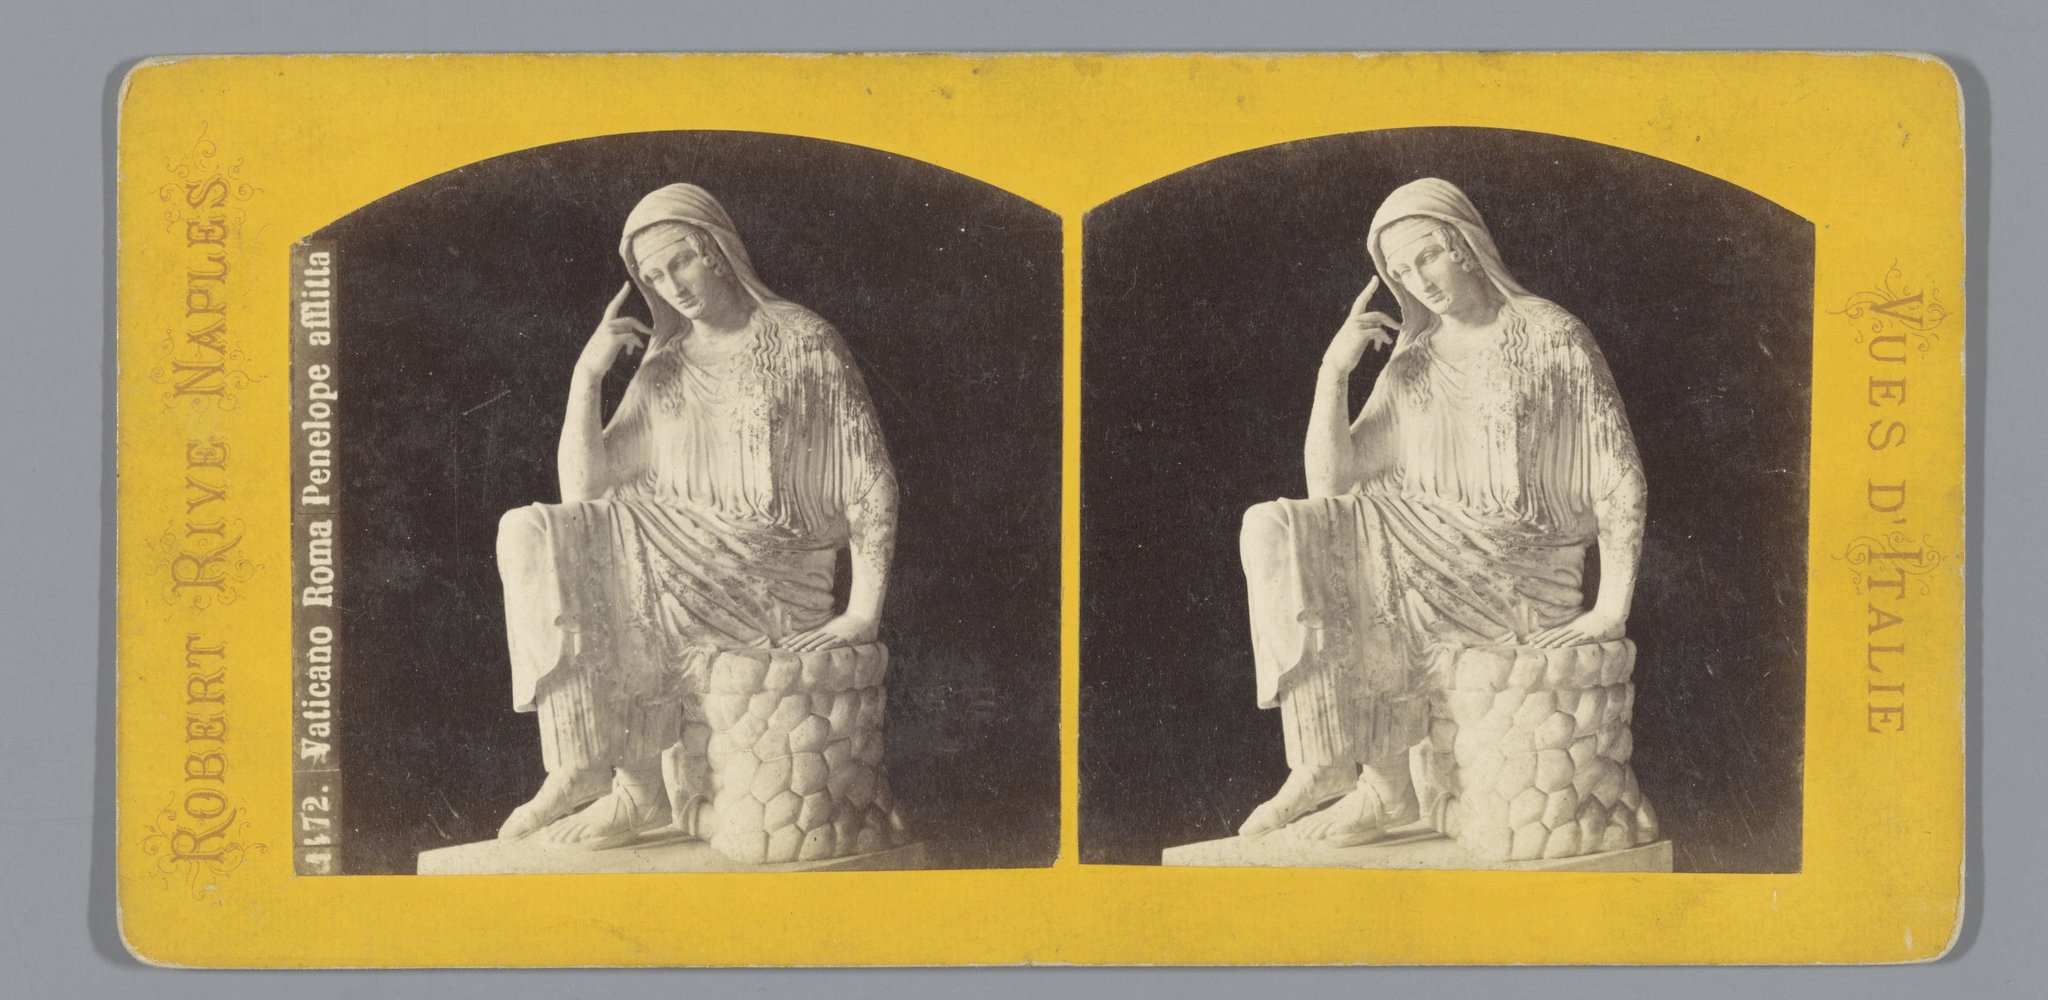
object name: stereograph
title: Vaticano Roma Penelope afflita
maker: roberto rive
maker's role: fotograaf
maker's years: 1825-1868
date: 1860-1880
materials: cardboard, photographic support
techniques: albumen print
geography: vatican museums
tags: piece of sculpture, reproduction of a piece of sculpture, penelope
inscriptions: number: ‘1472.’